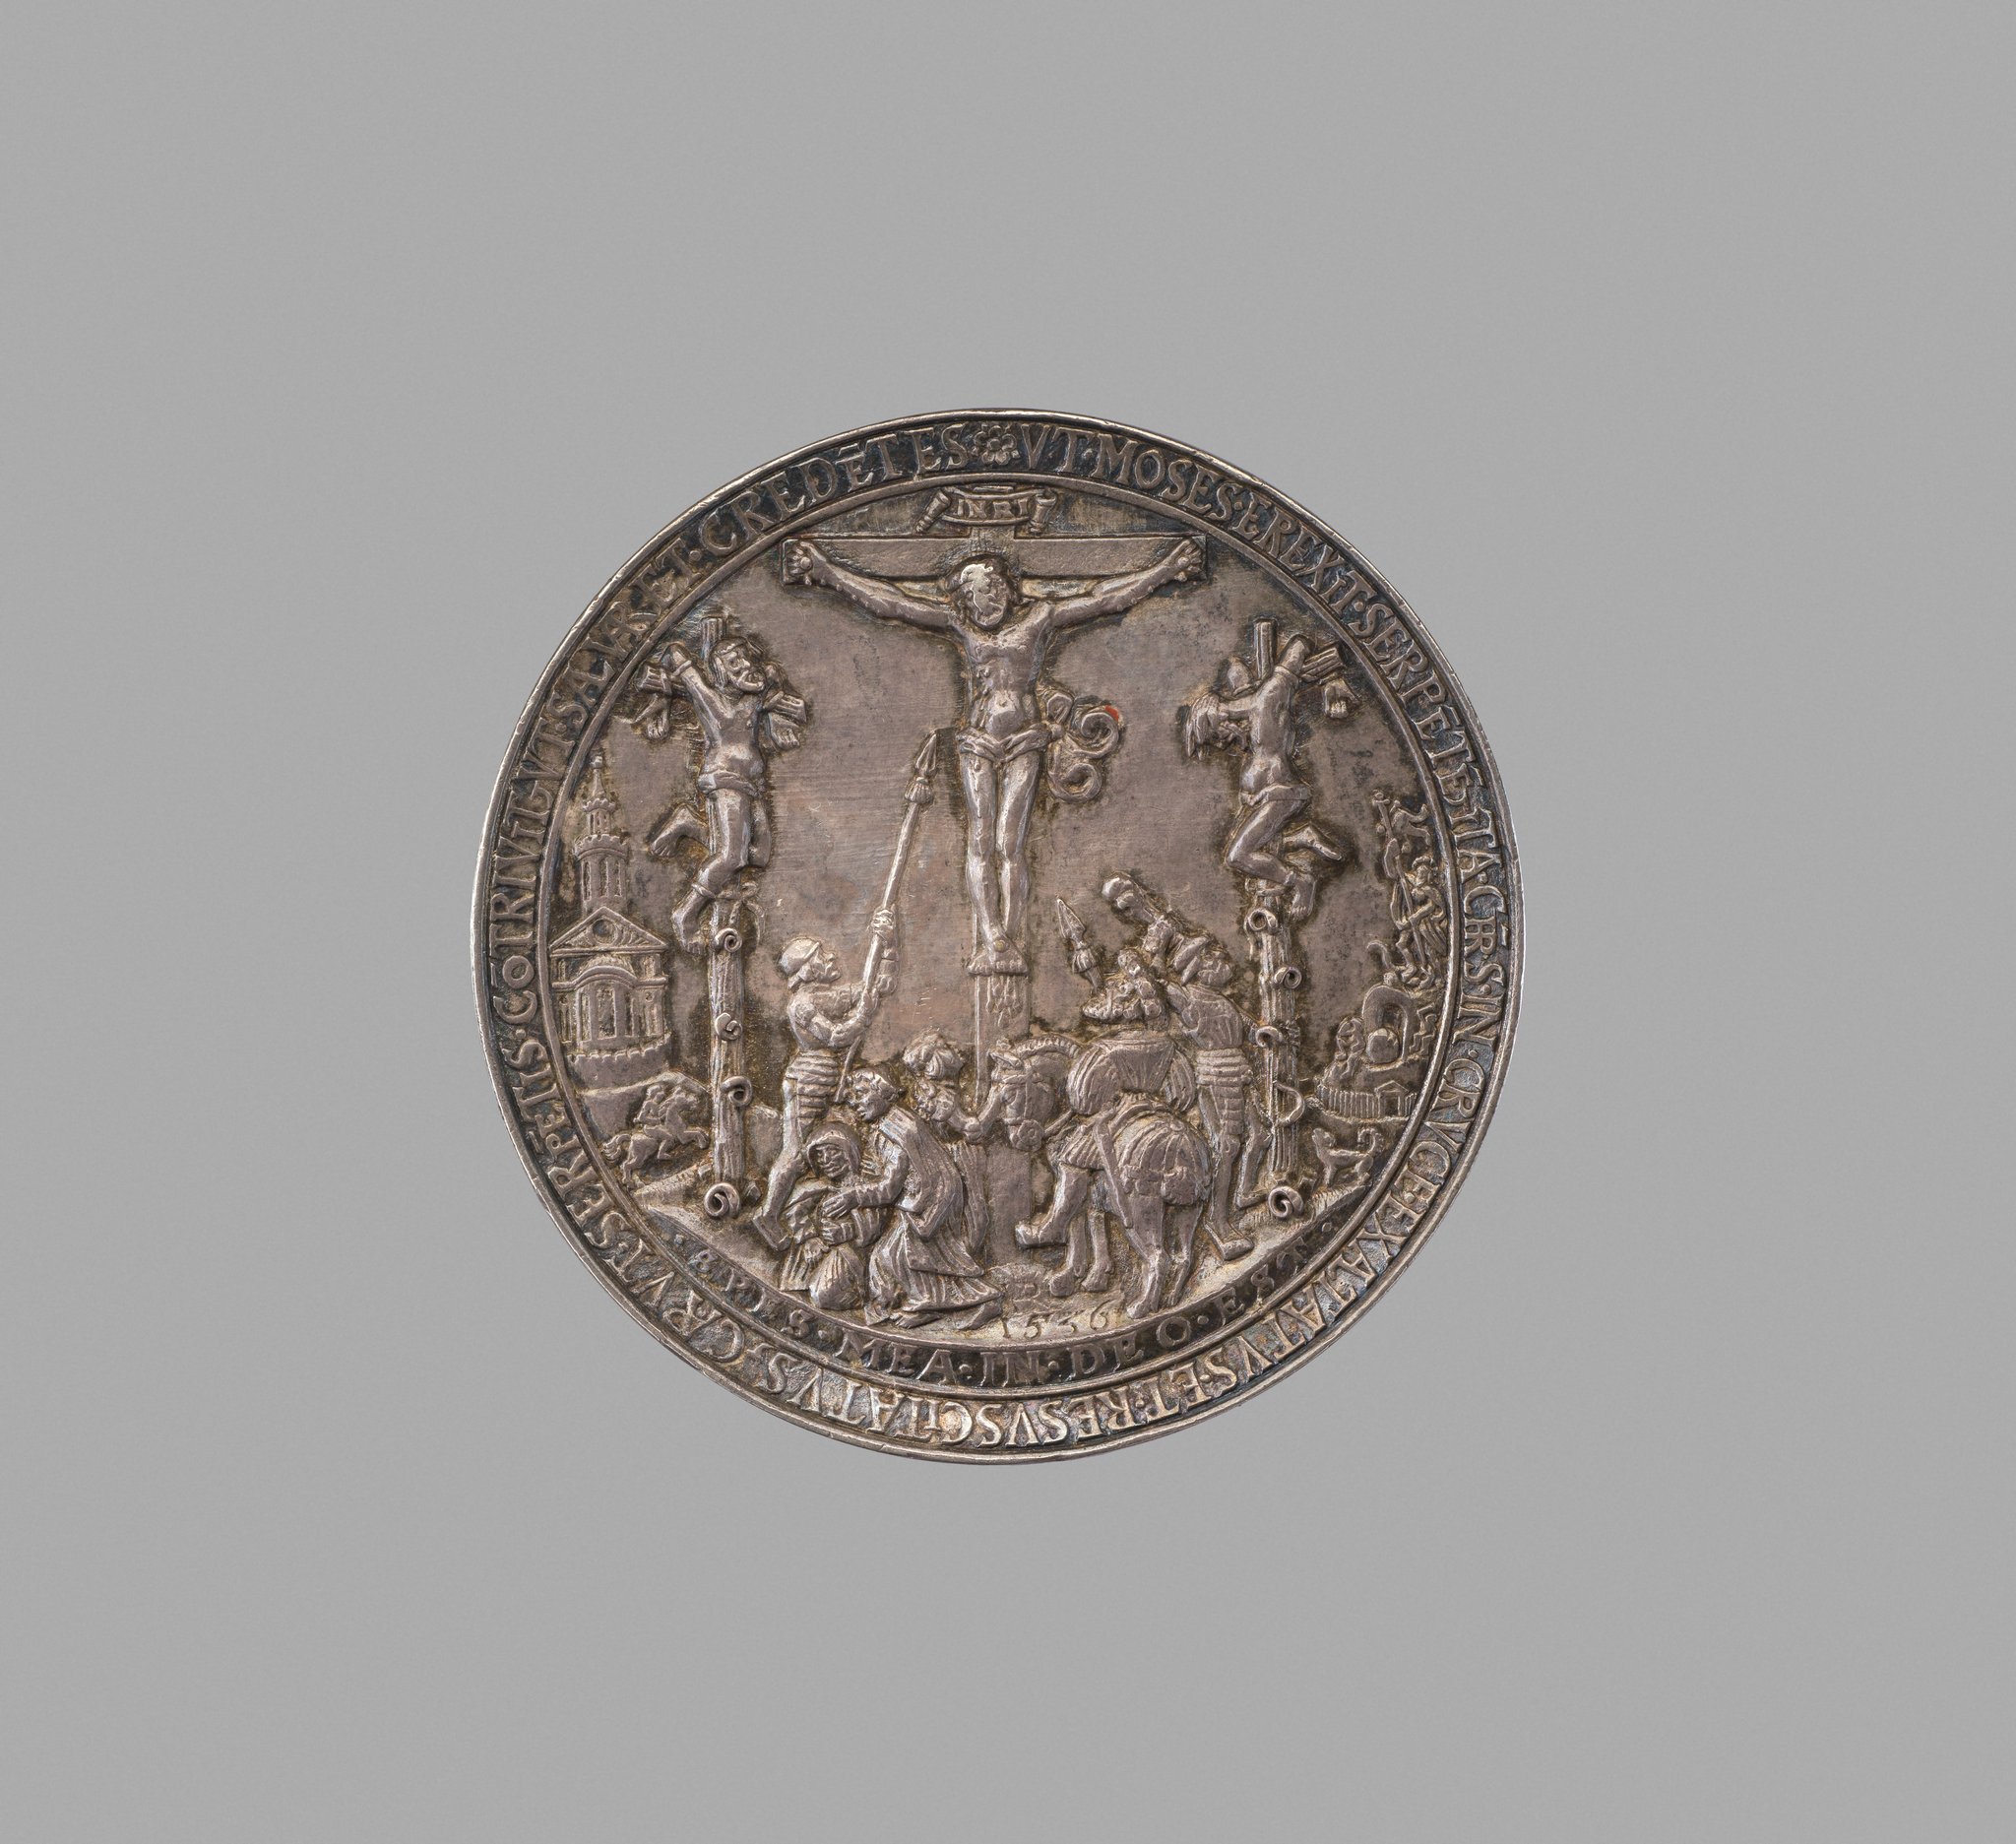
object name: medal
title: The Temptation of Adam and Eve and The Crucifixion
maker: hans reinhart the elder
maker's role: artist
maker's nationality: german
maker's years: 1500-1581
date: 1536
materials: silver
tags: christ,adam,eve,crucifixion